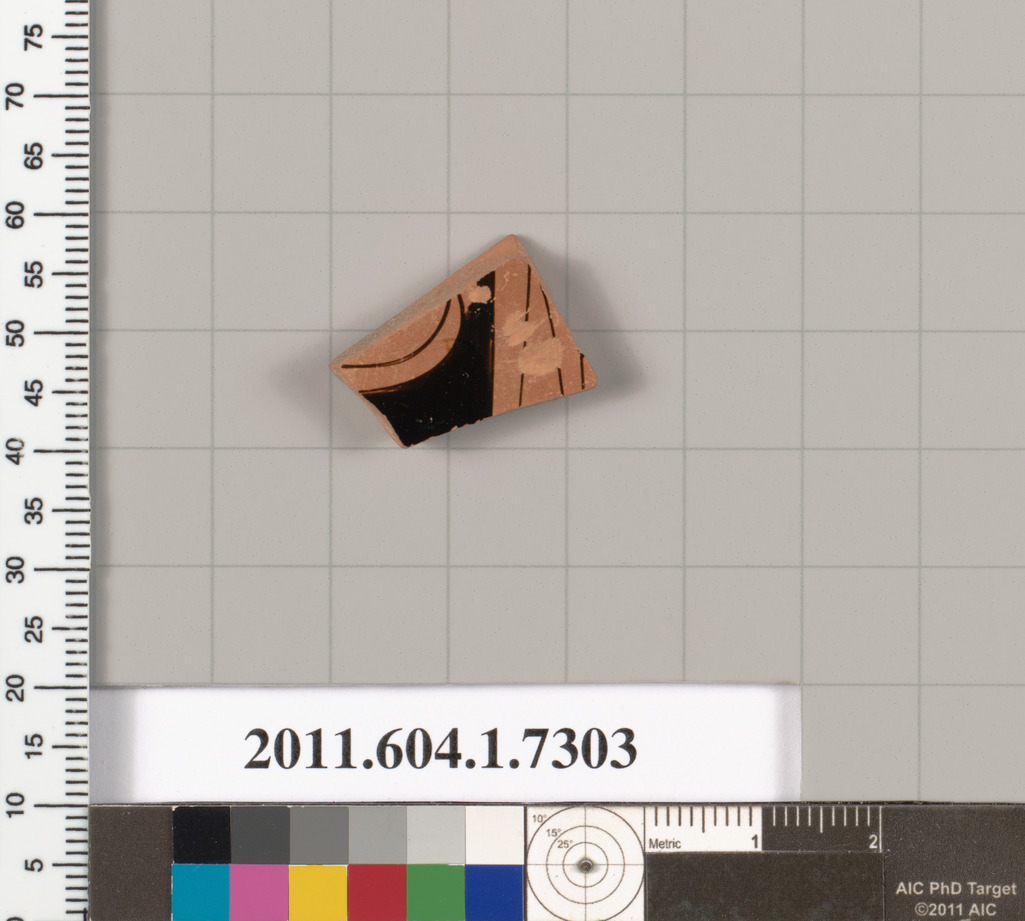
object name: kylix fragment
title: Terracotta fragment of a kylix (drinking cup)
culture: greek, attic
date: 500-480 BCE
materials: terracotta